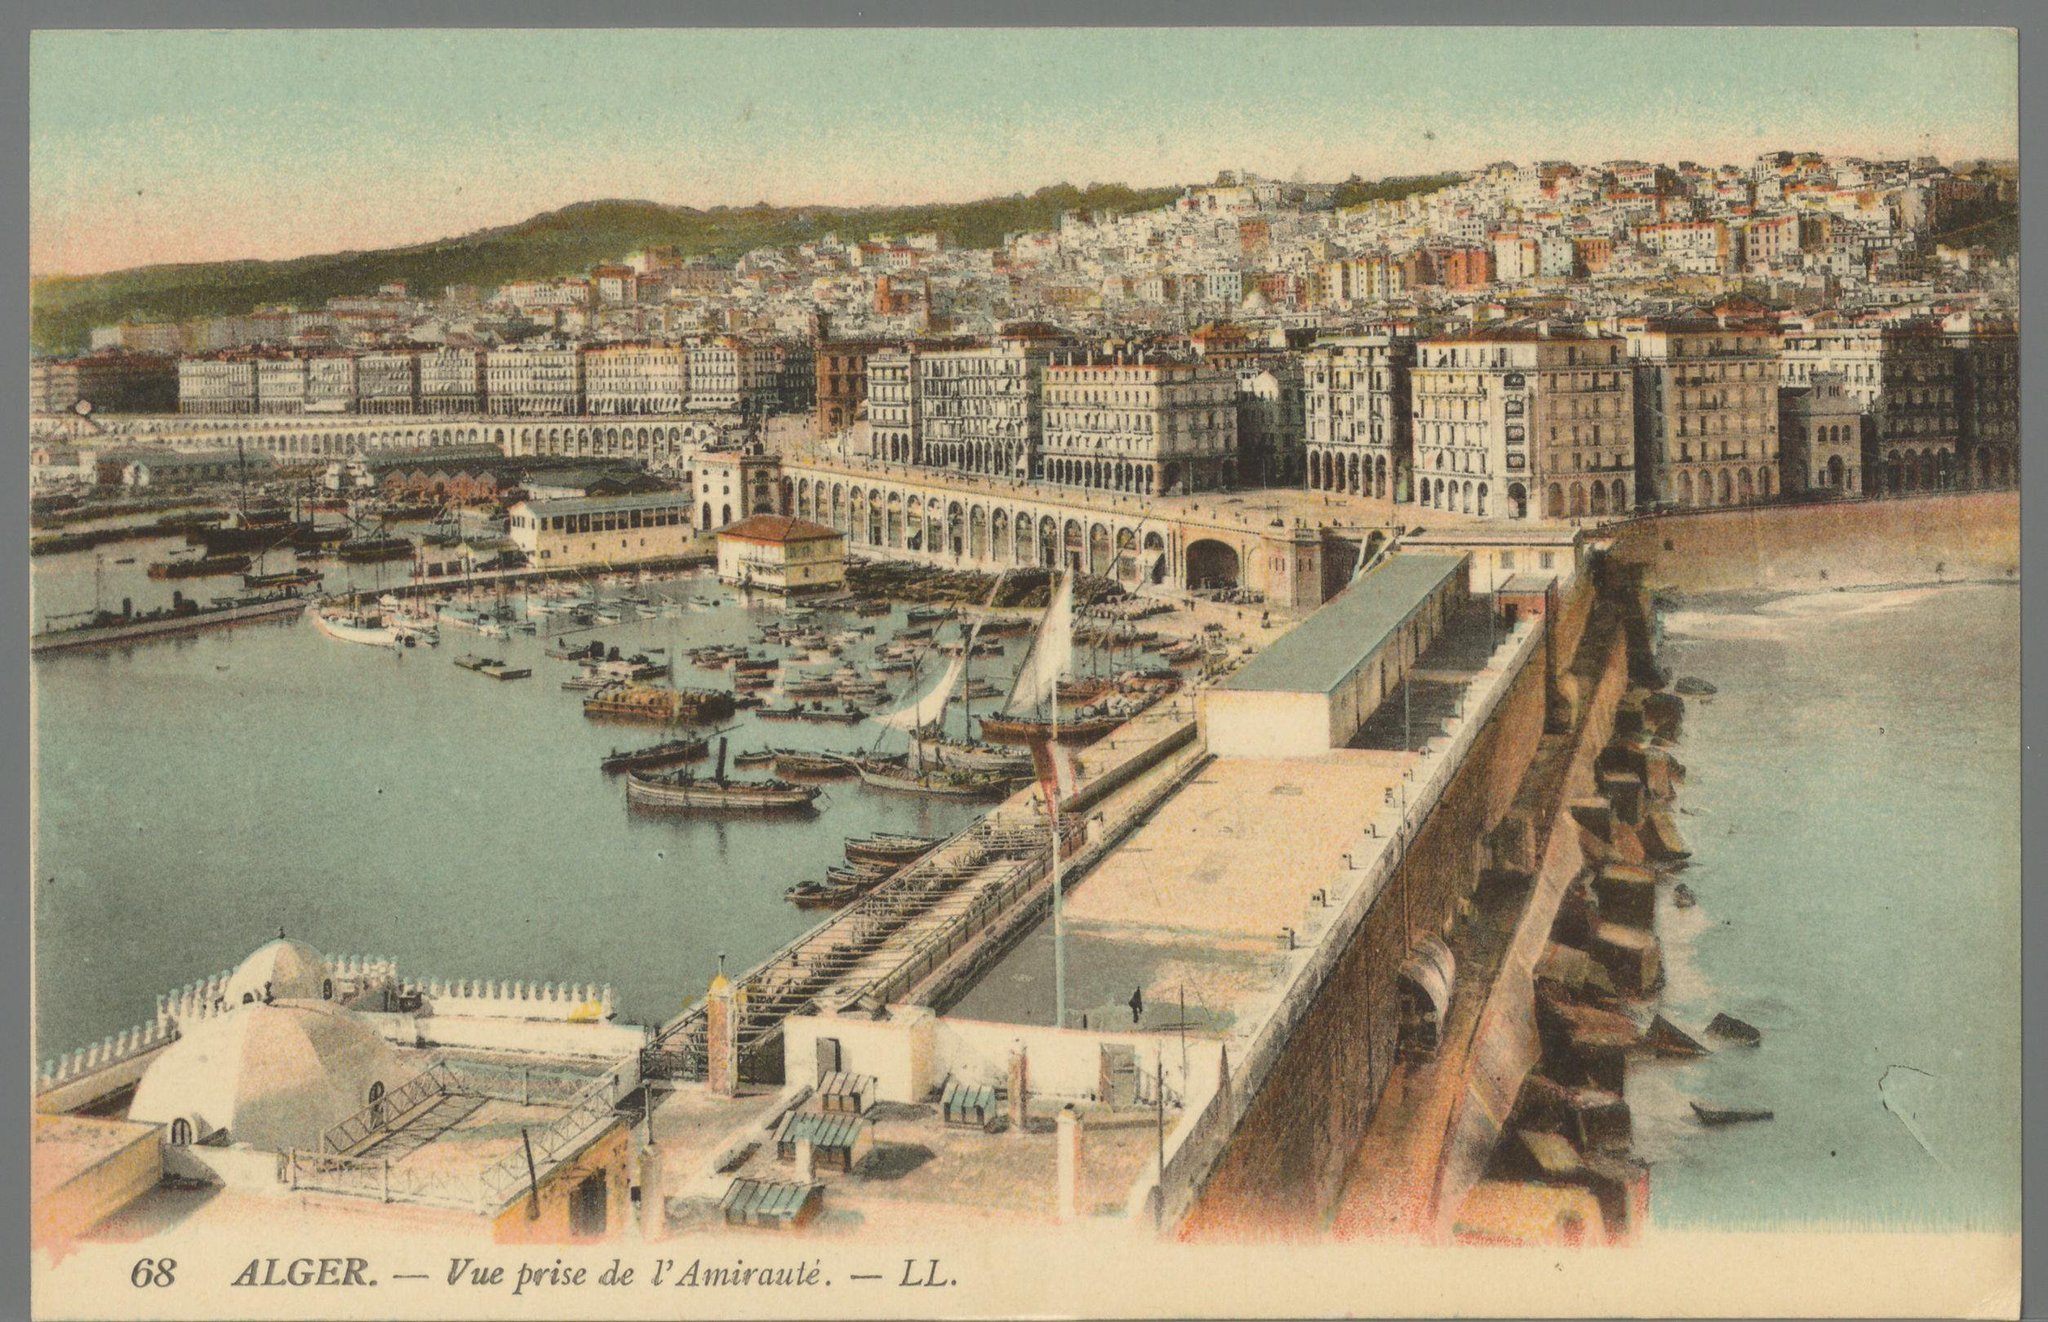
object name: photomechanical print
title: Alger. Vue prise de l'Amirauté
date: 1903-1920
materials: cardboard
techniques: photograph, lithograph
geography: algiers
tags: harbour, prospect of city, town panorama, silhouette of city (+ city(-scape) with figures, staffage)